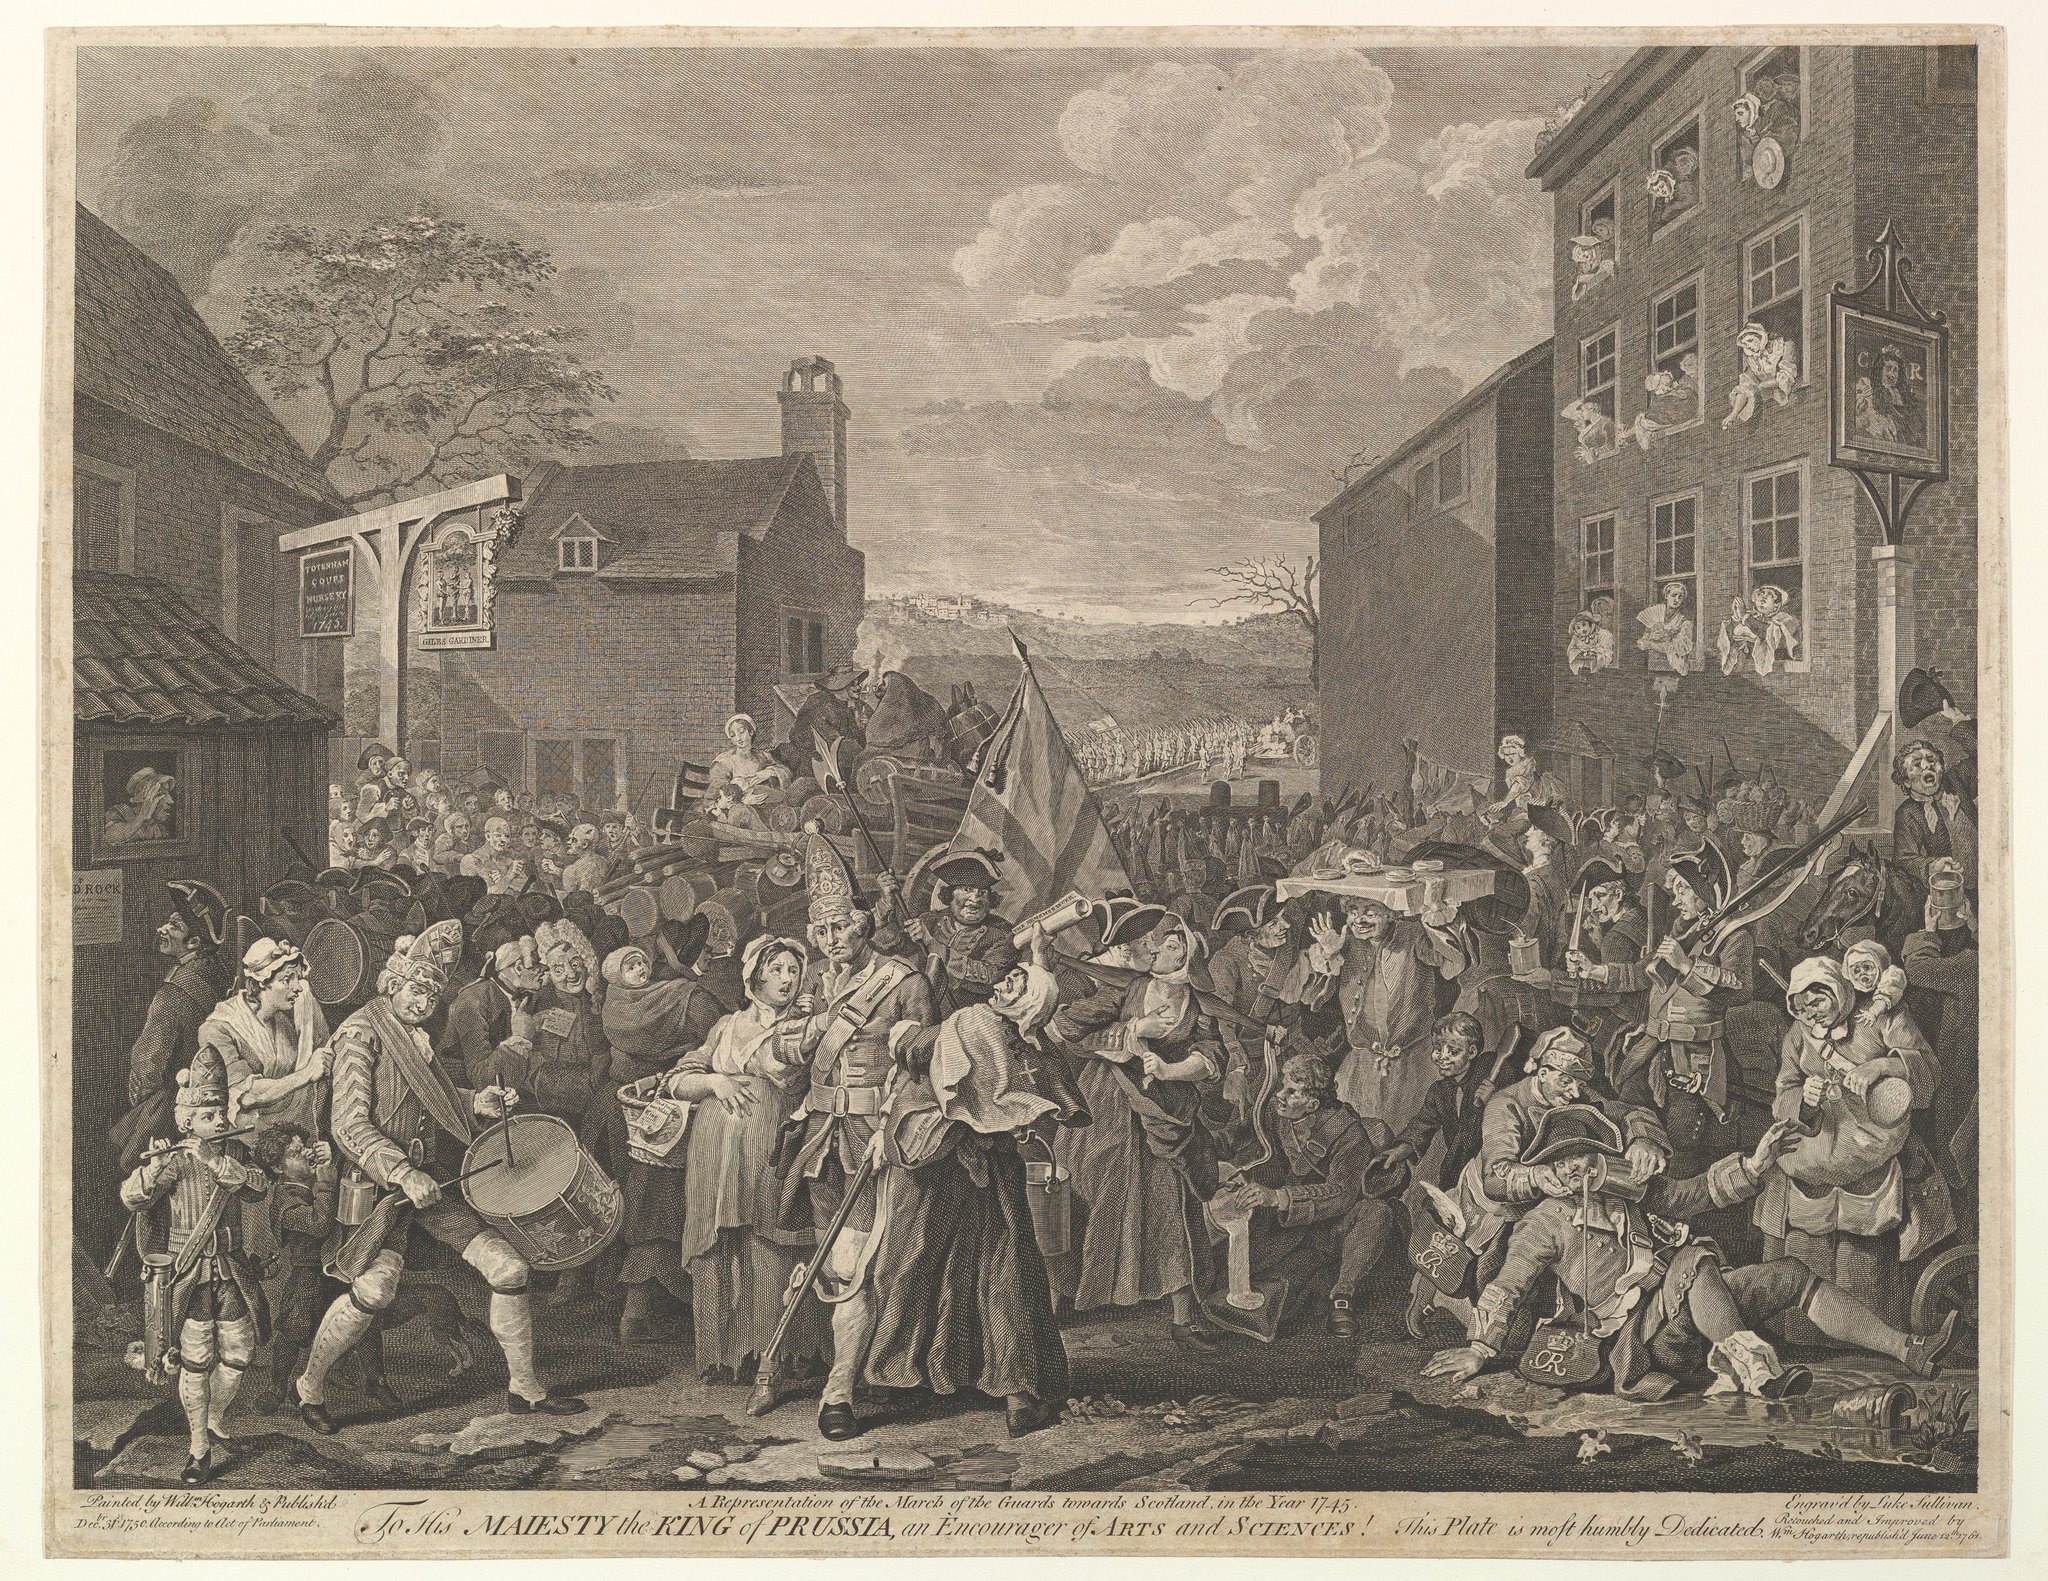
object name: print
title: The March to Finchley--A Representation of the March of the Guards towards Scotland in the Year 1745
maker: luke sullivan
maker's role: engraver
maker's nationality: irish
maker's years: 1705-1771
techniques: engraving, etching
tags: men,women,drums,flags